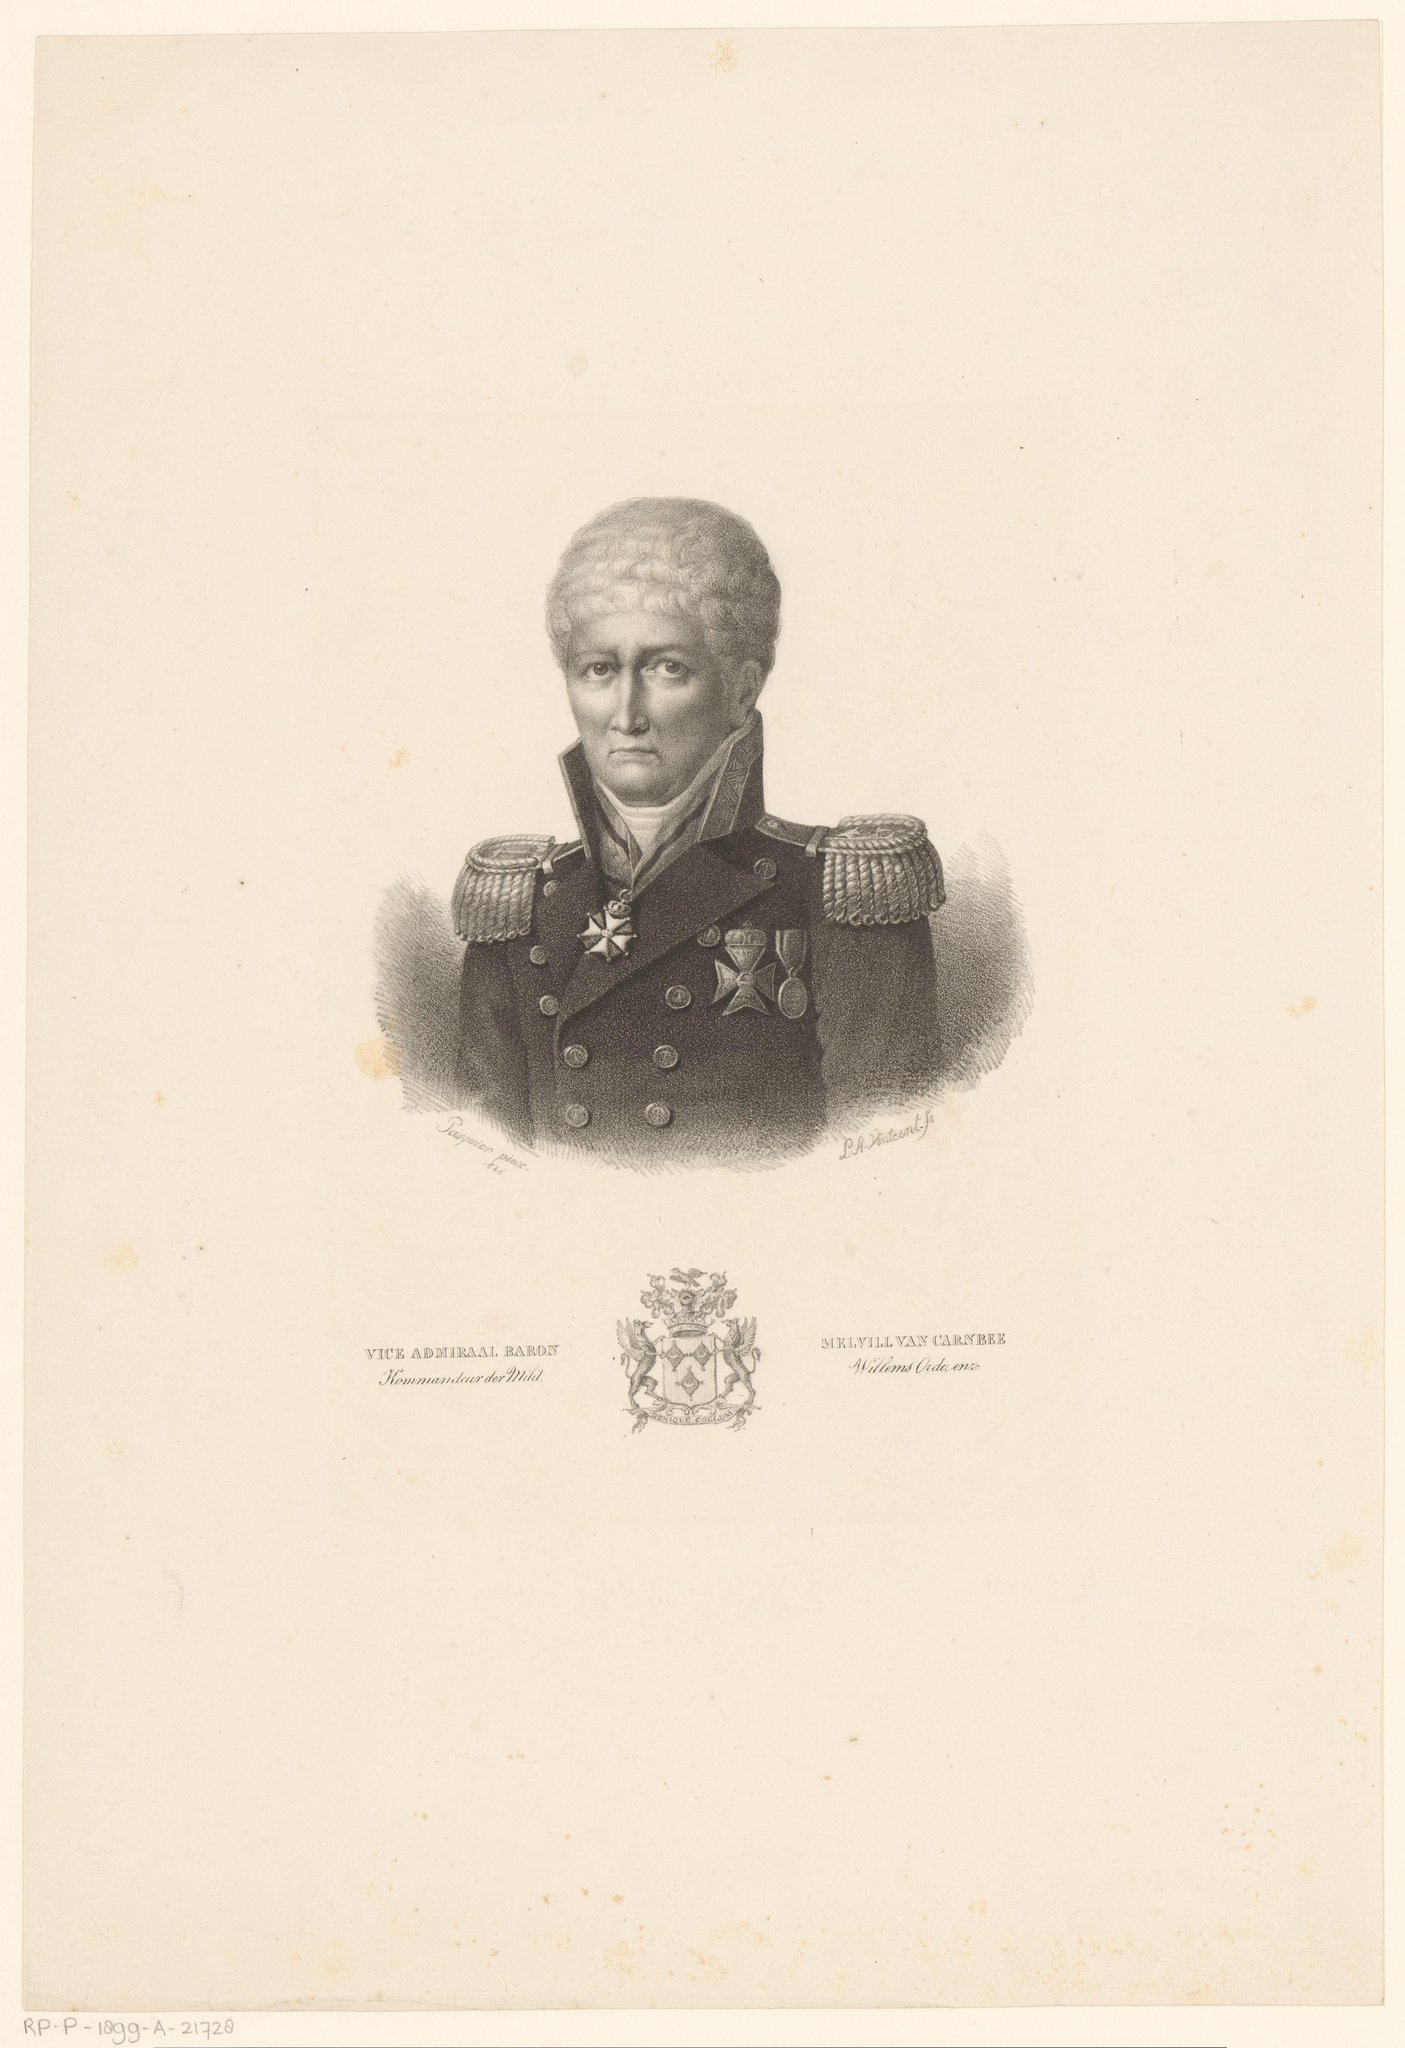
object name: print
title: Portret van Pieter Melvill van Carnbee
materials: paper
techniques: lithograph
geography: netherlands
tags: dordrecht, the hague, naval officer, pieter melvill van carnbee, historical persons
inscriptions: collector's mark: Lugt 2228